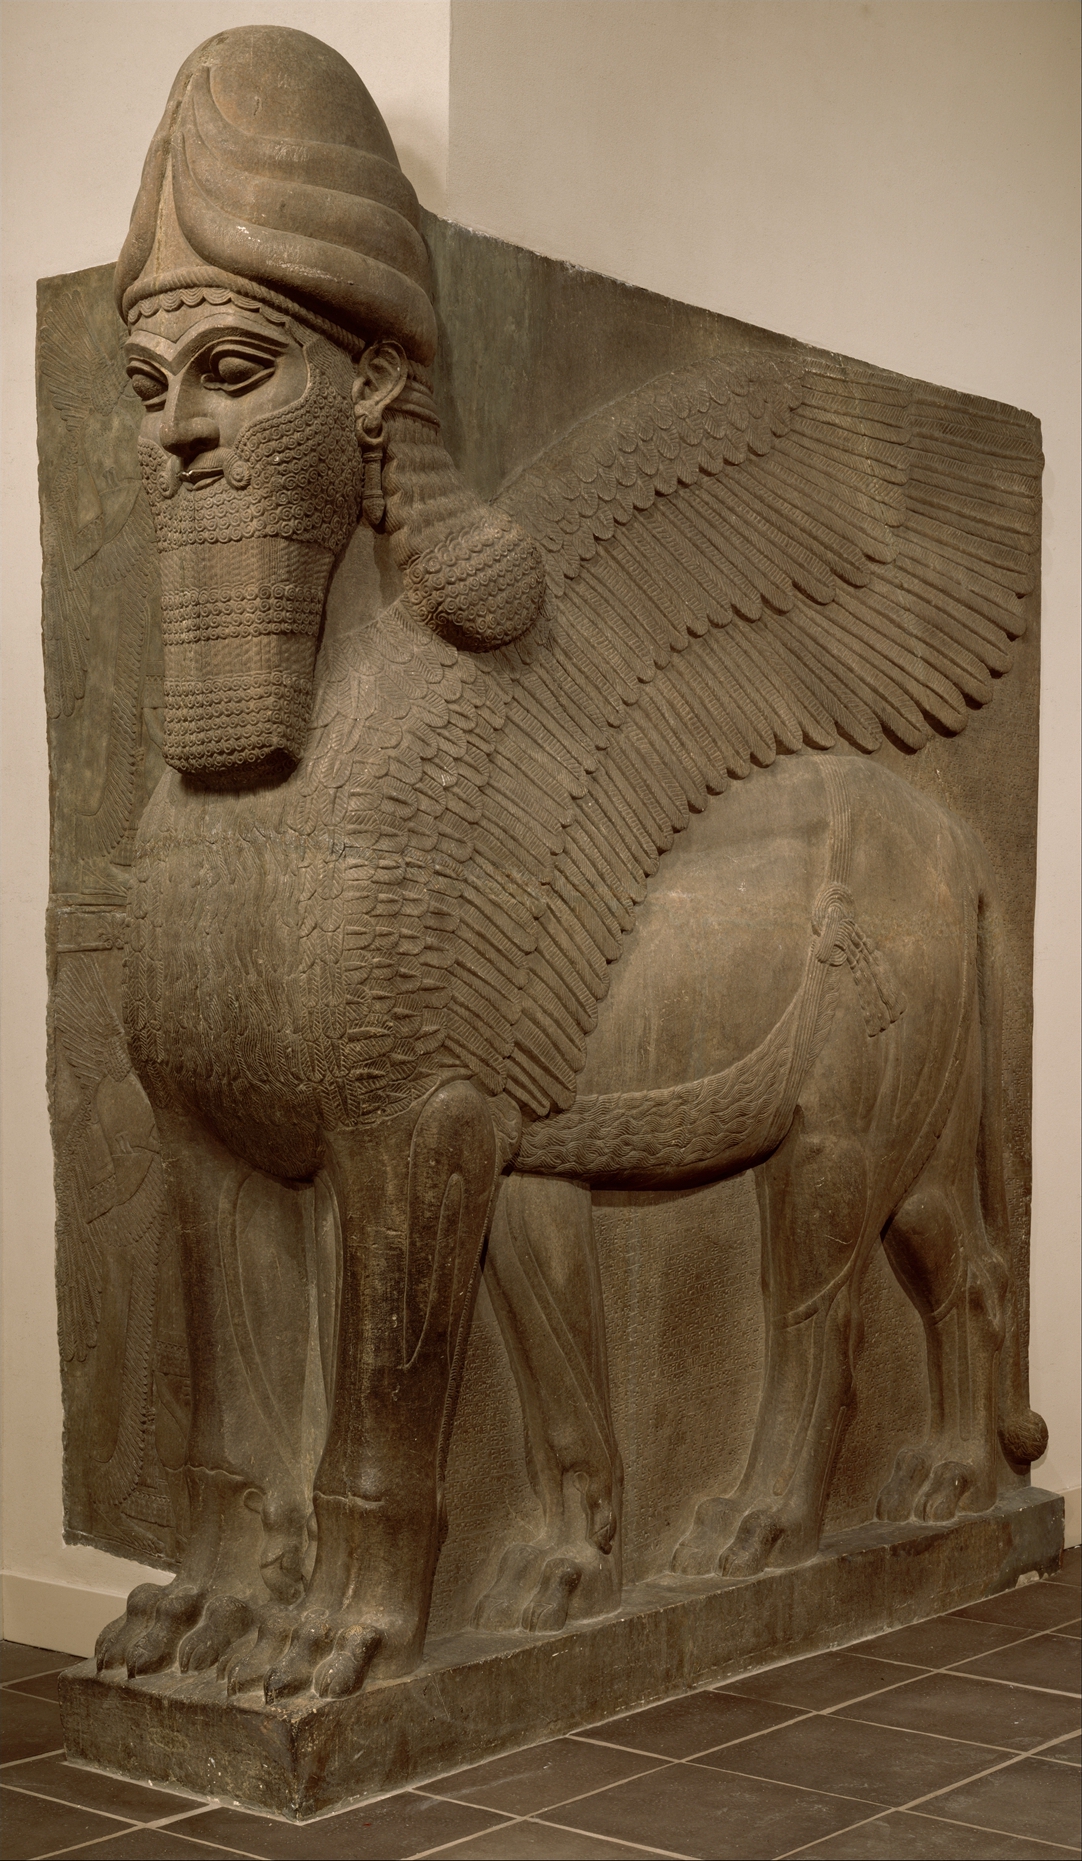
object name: relief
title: Human-headed winged lion (lamassu)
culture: assyrian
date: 883-859 BCE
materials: alabaster, gypsum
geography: mesopotamia